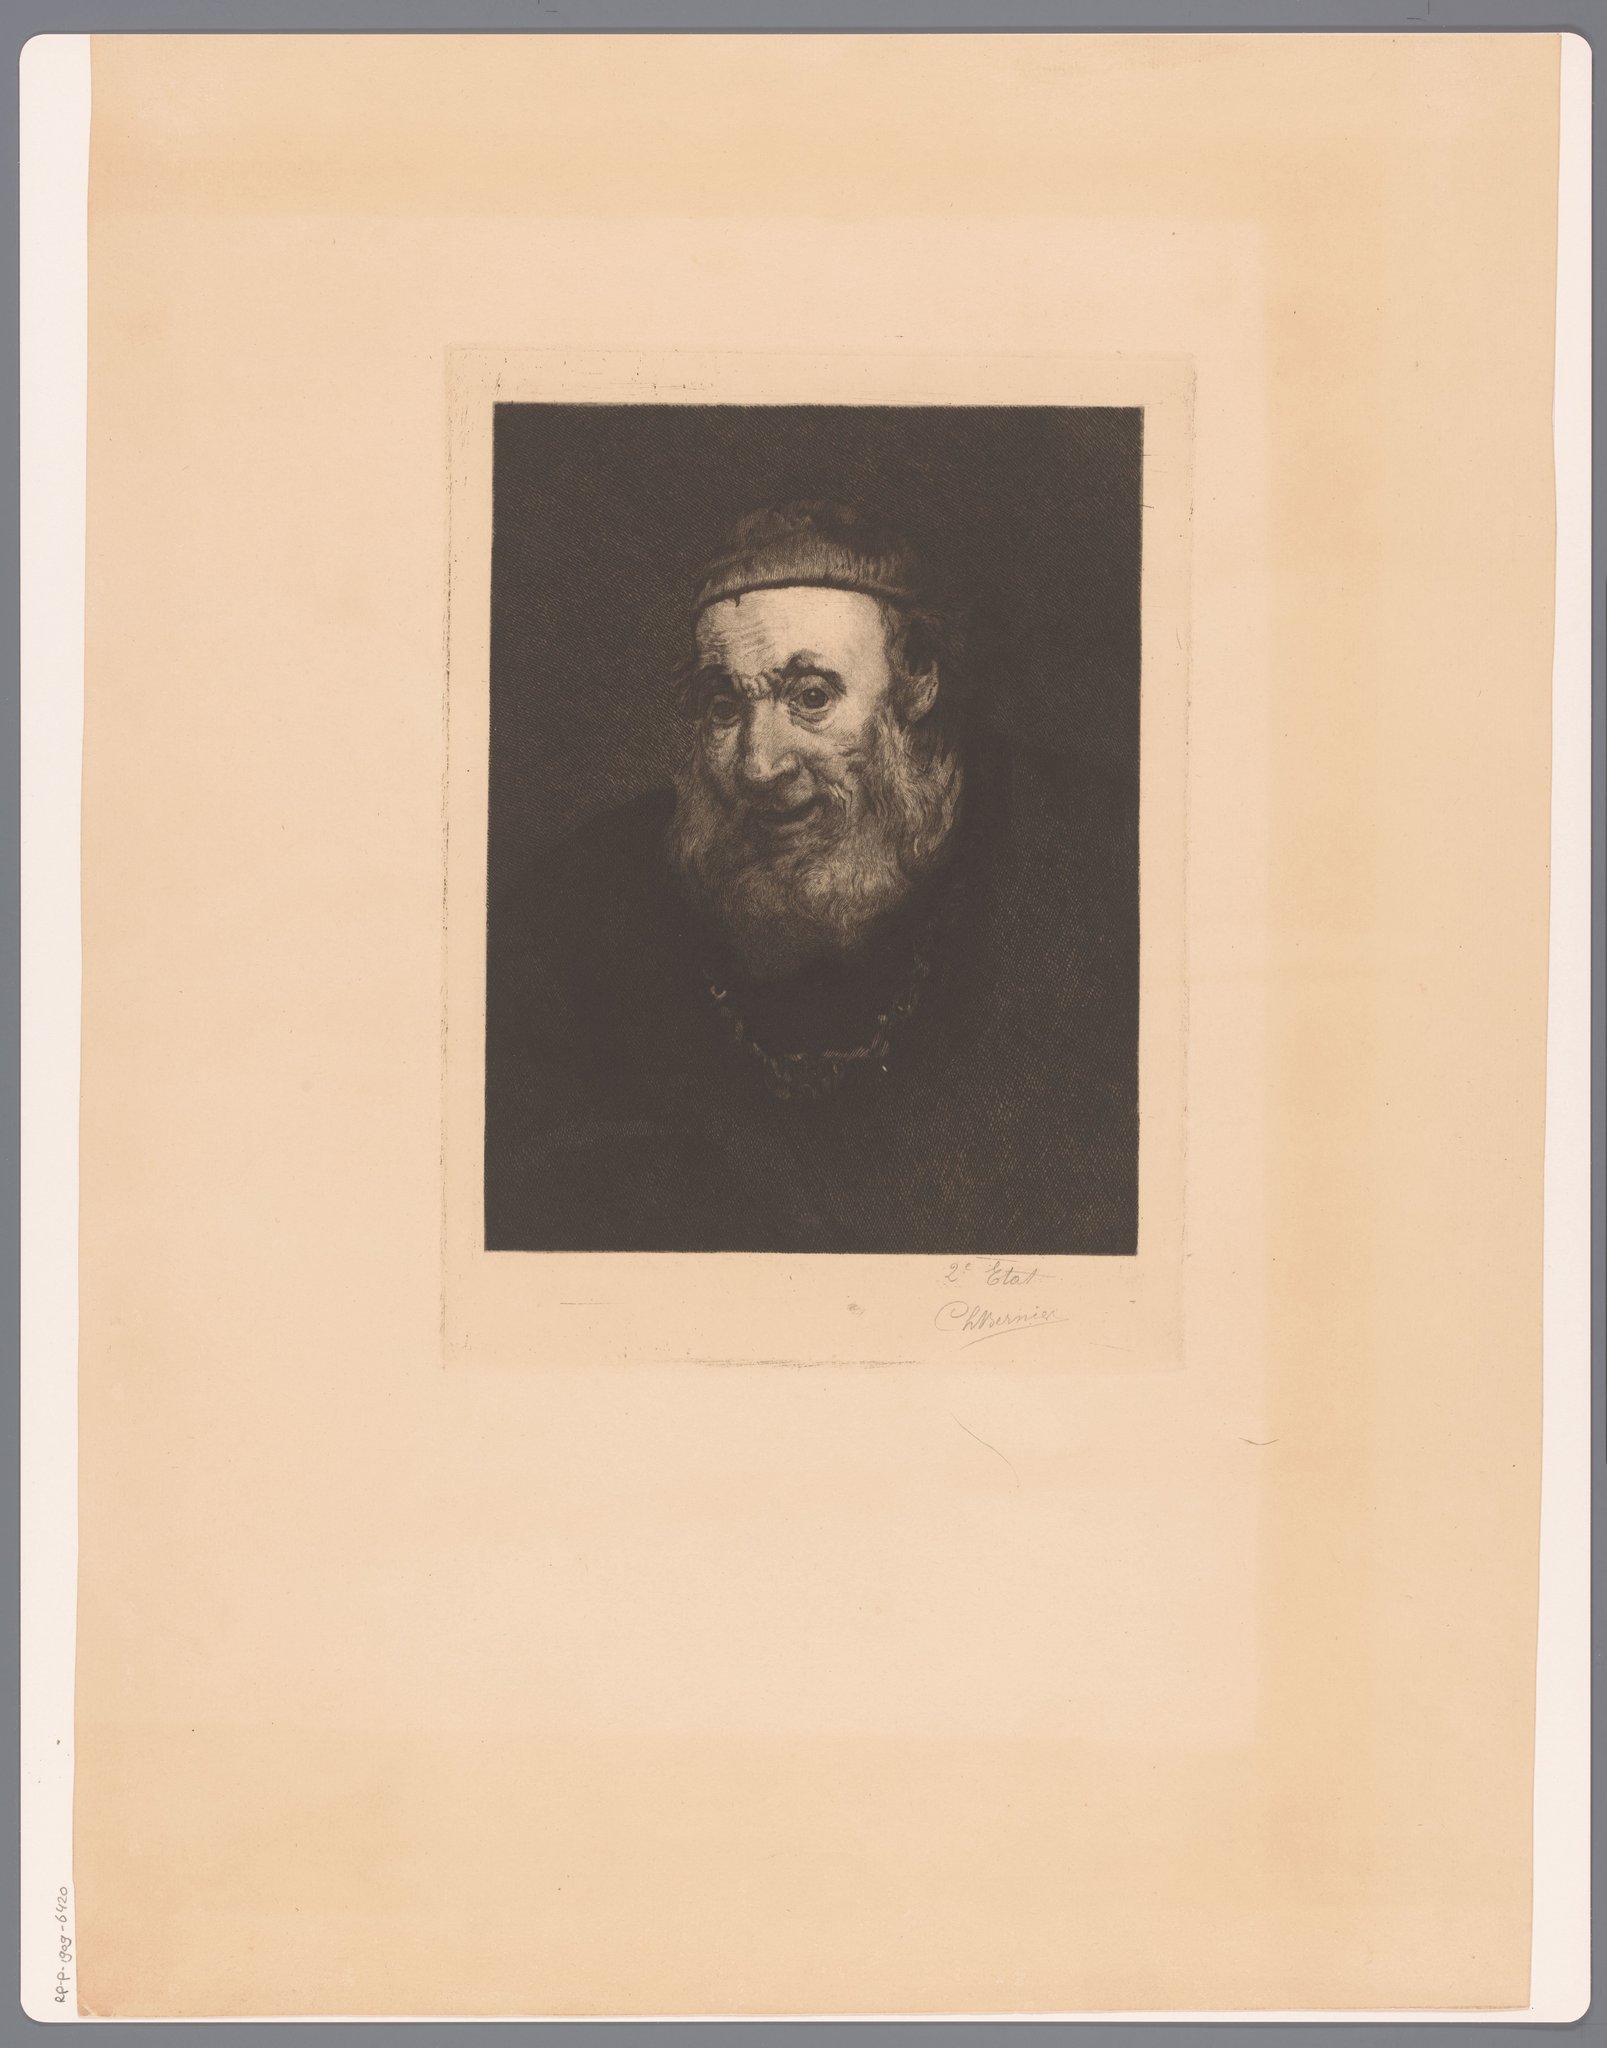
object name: print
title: Kop van een grijsaard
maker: charles théodore bernier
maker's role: print maker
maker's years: 1871-1950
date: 1887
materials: paper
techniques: drypoint, etching, intaglio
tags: old man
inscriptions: collector's mark